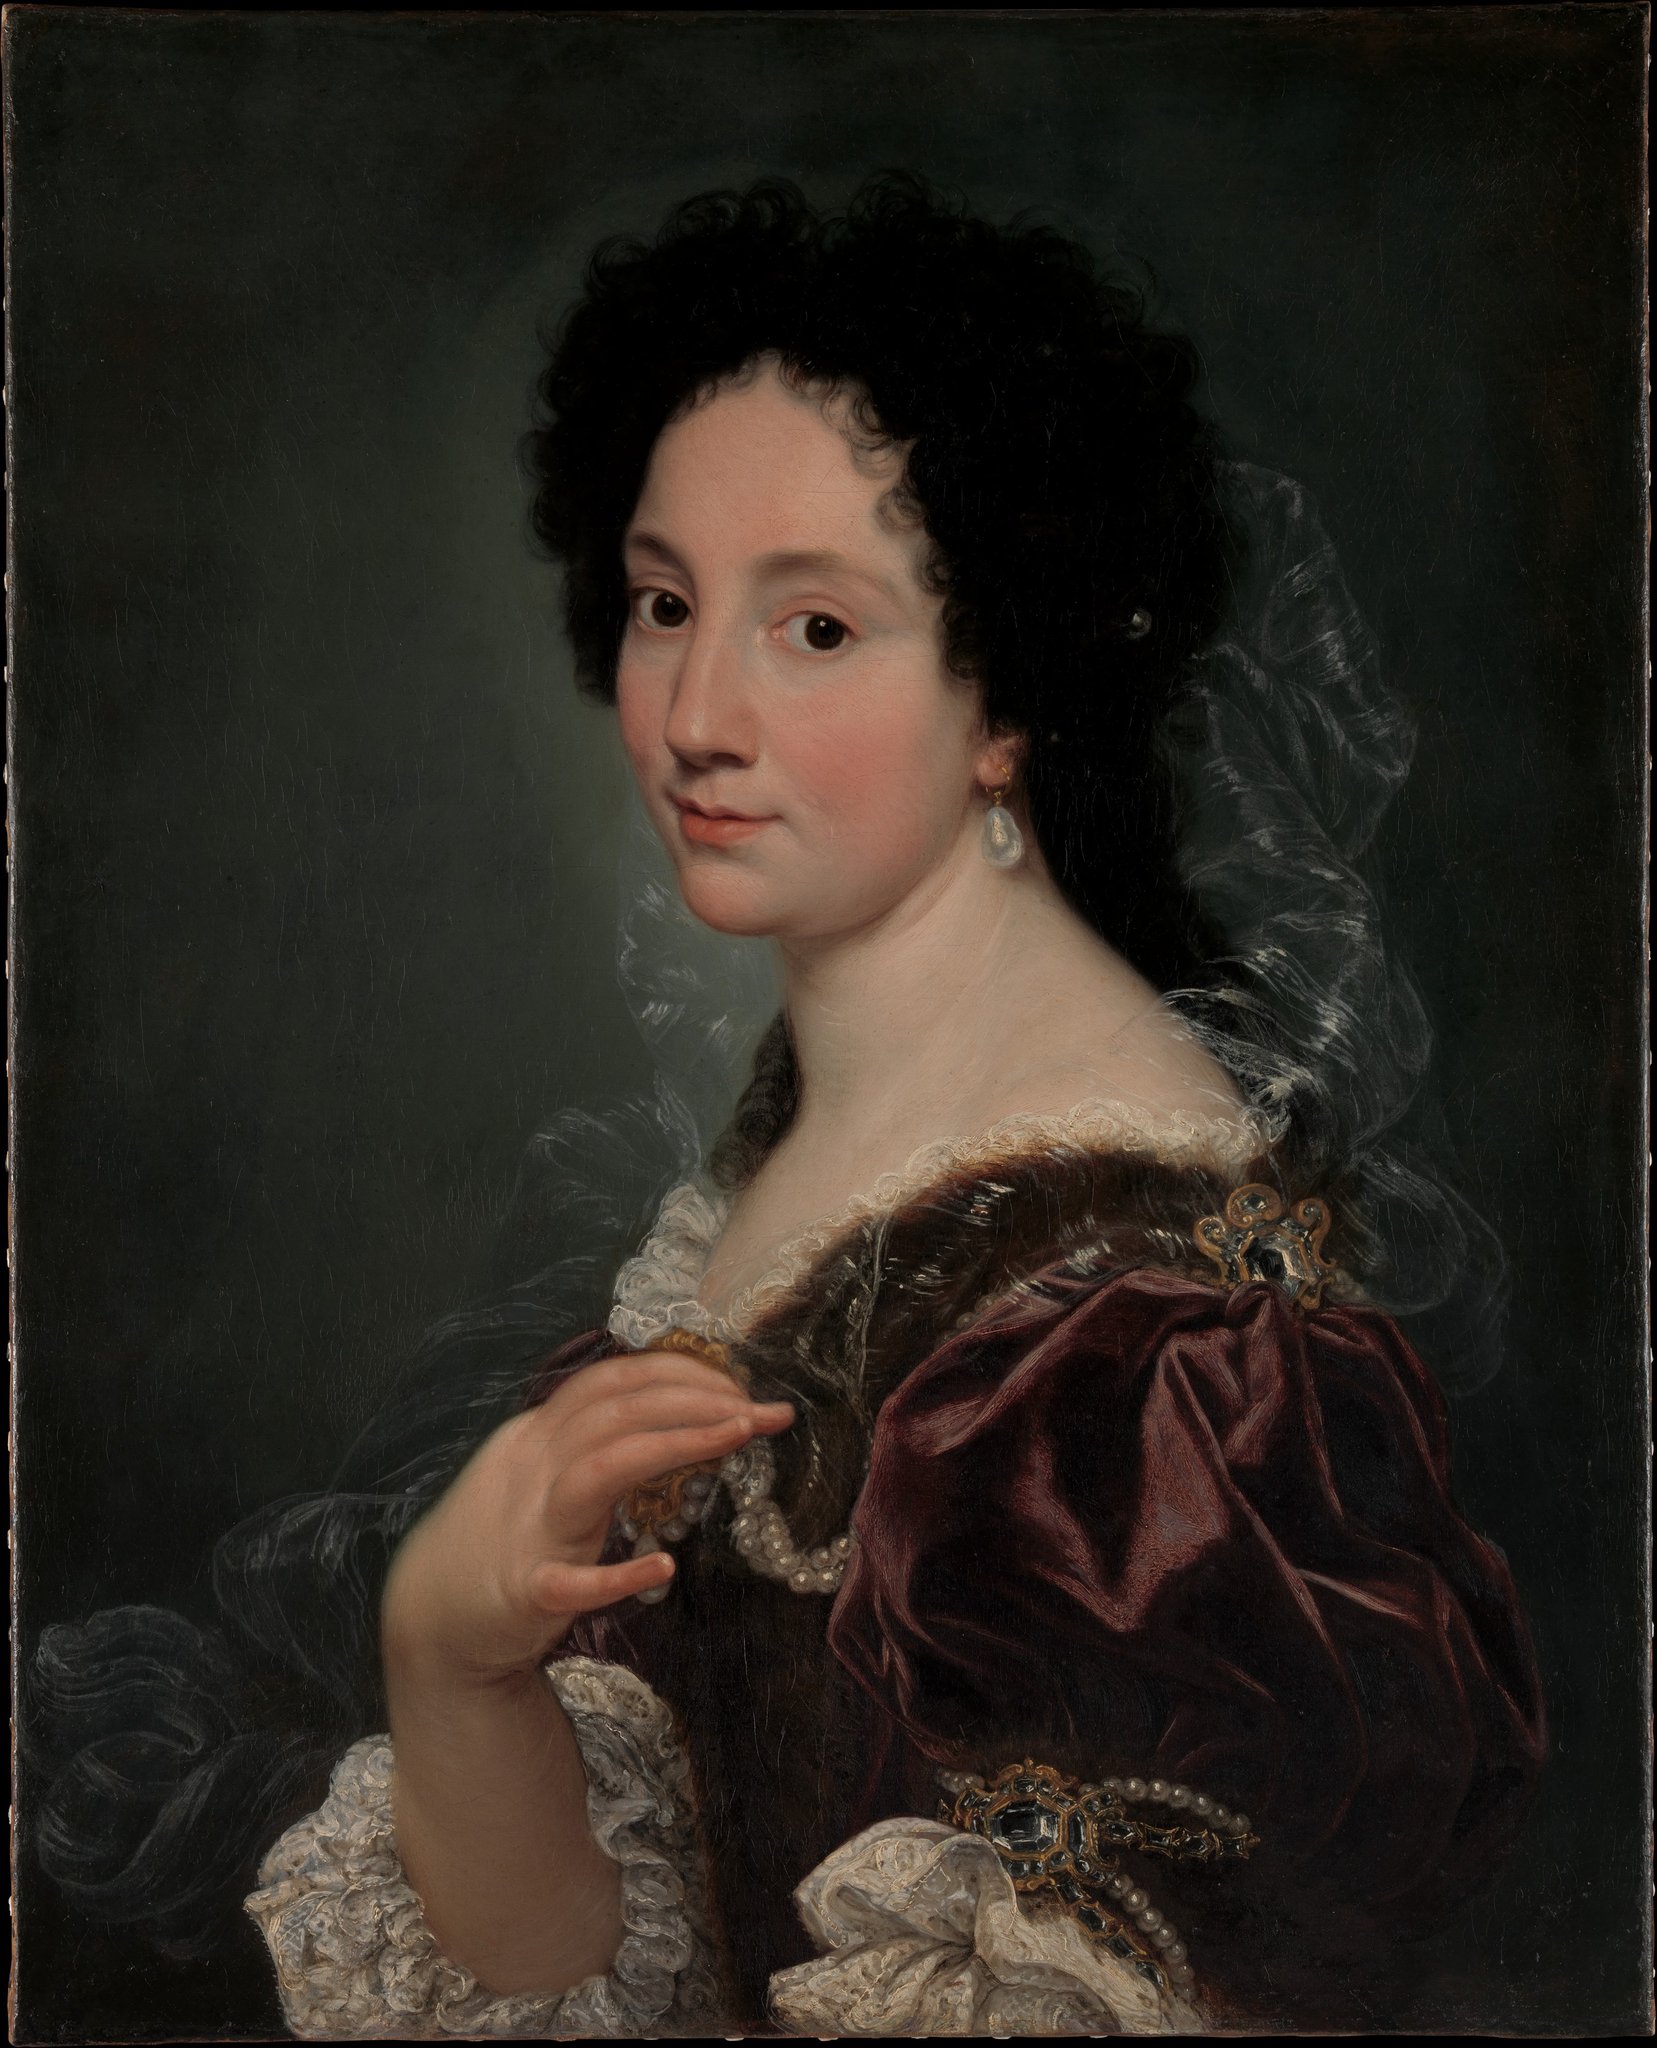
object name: painting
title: Portrait of a Woman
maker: giovanni battista gaulli (il baciccio)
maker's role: artist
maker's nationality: italian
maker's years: 1639-1709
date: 1670-1679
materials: canvas, oil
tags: portraits,women